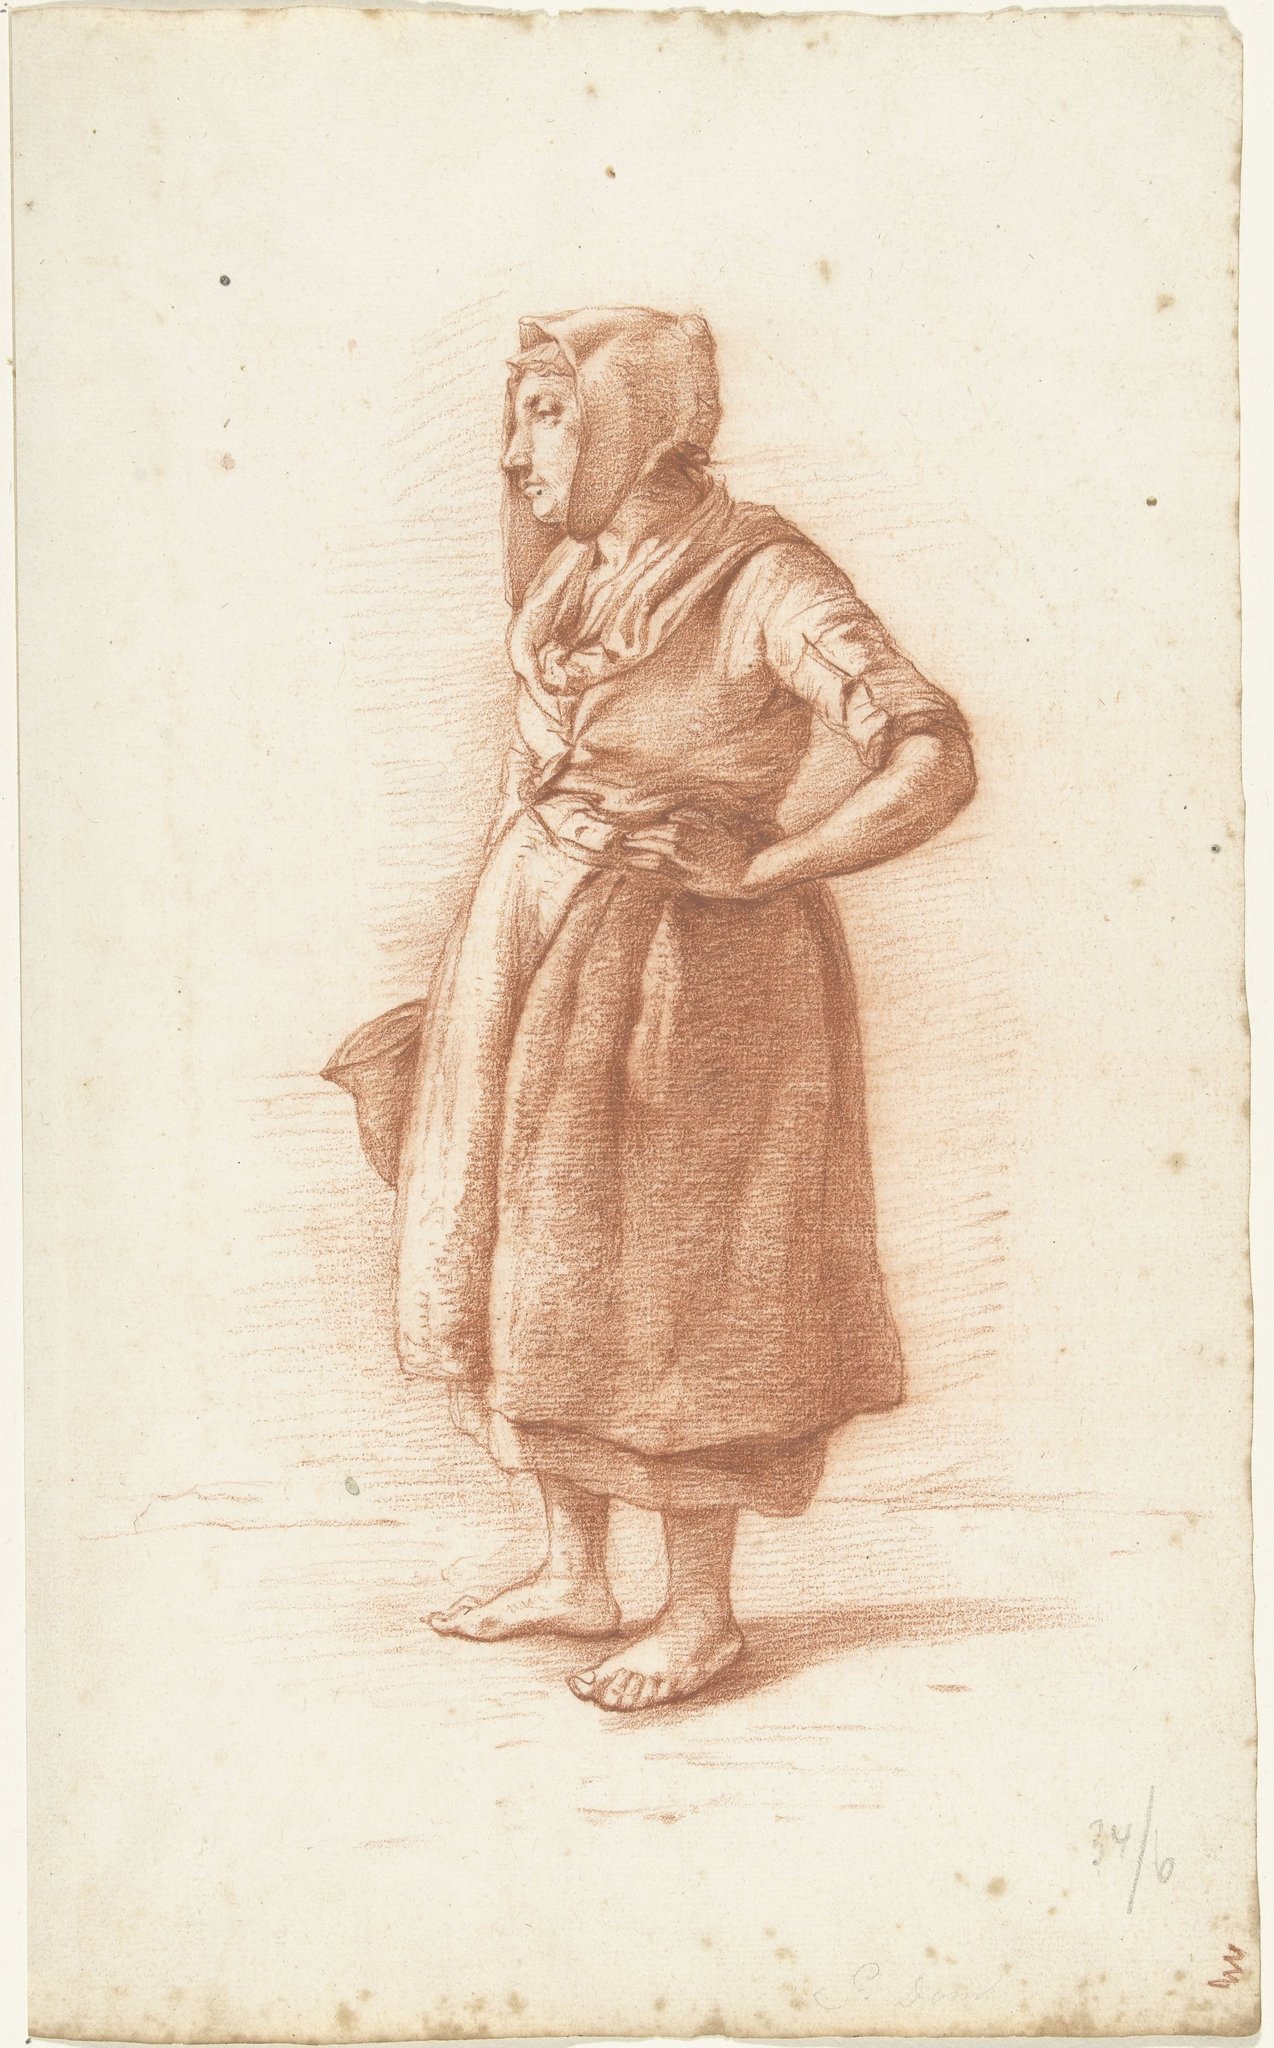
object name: drawing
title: Staande vrouw naar links, de hand in de zij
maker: abraham johannes ruytenschildt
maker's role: draughtsman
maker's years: 1778-1841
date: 1814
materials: chalk, paper